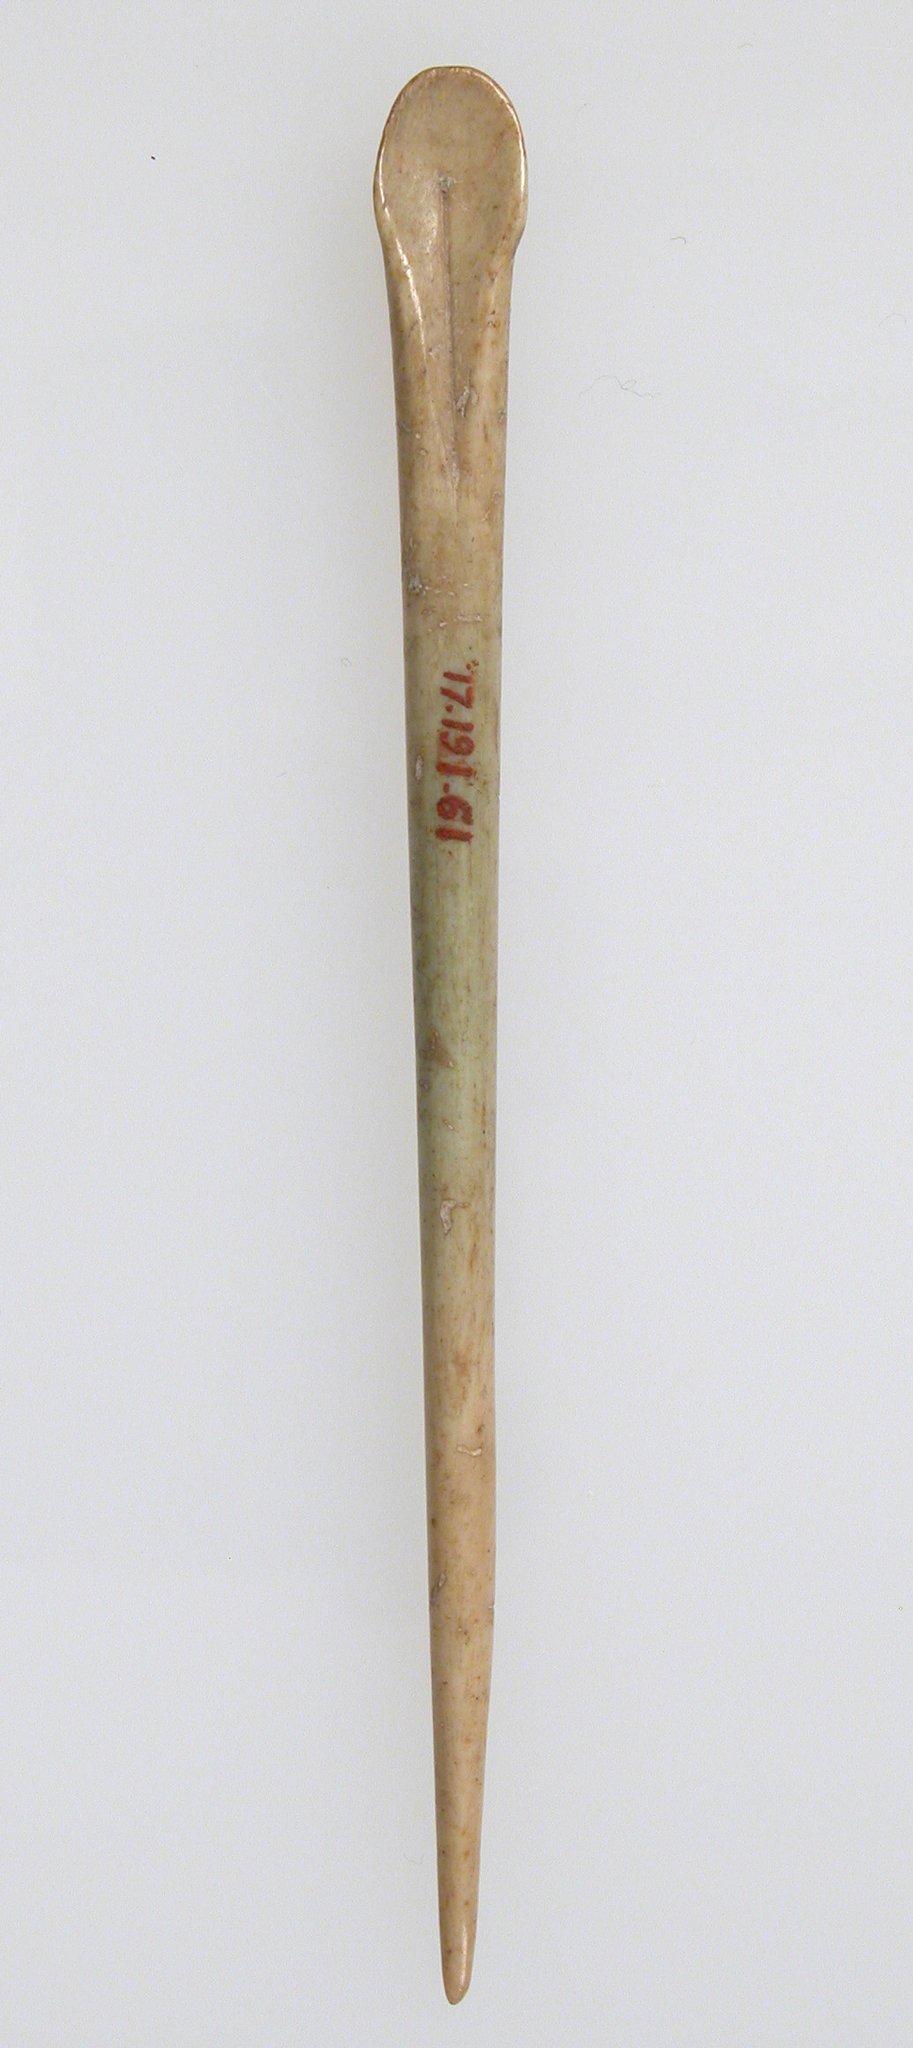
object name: implement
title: Toilet Implement in the Shape of a Pin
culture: roman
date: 200-500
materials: ivory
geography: northern france